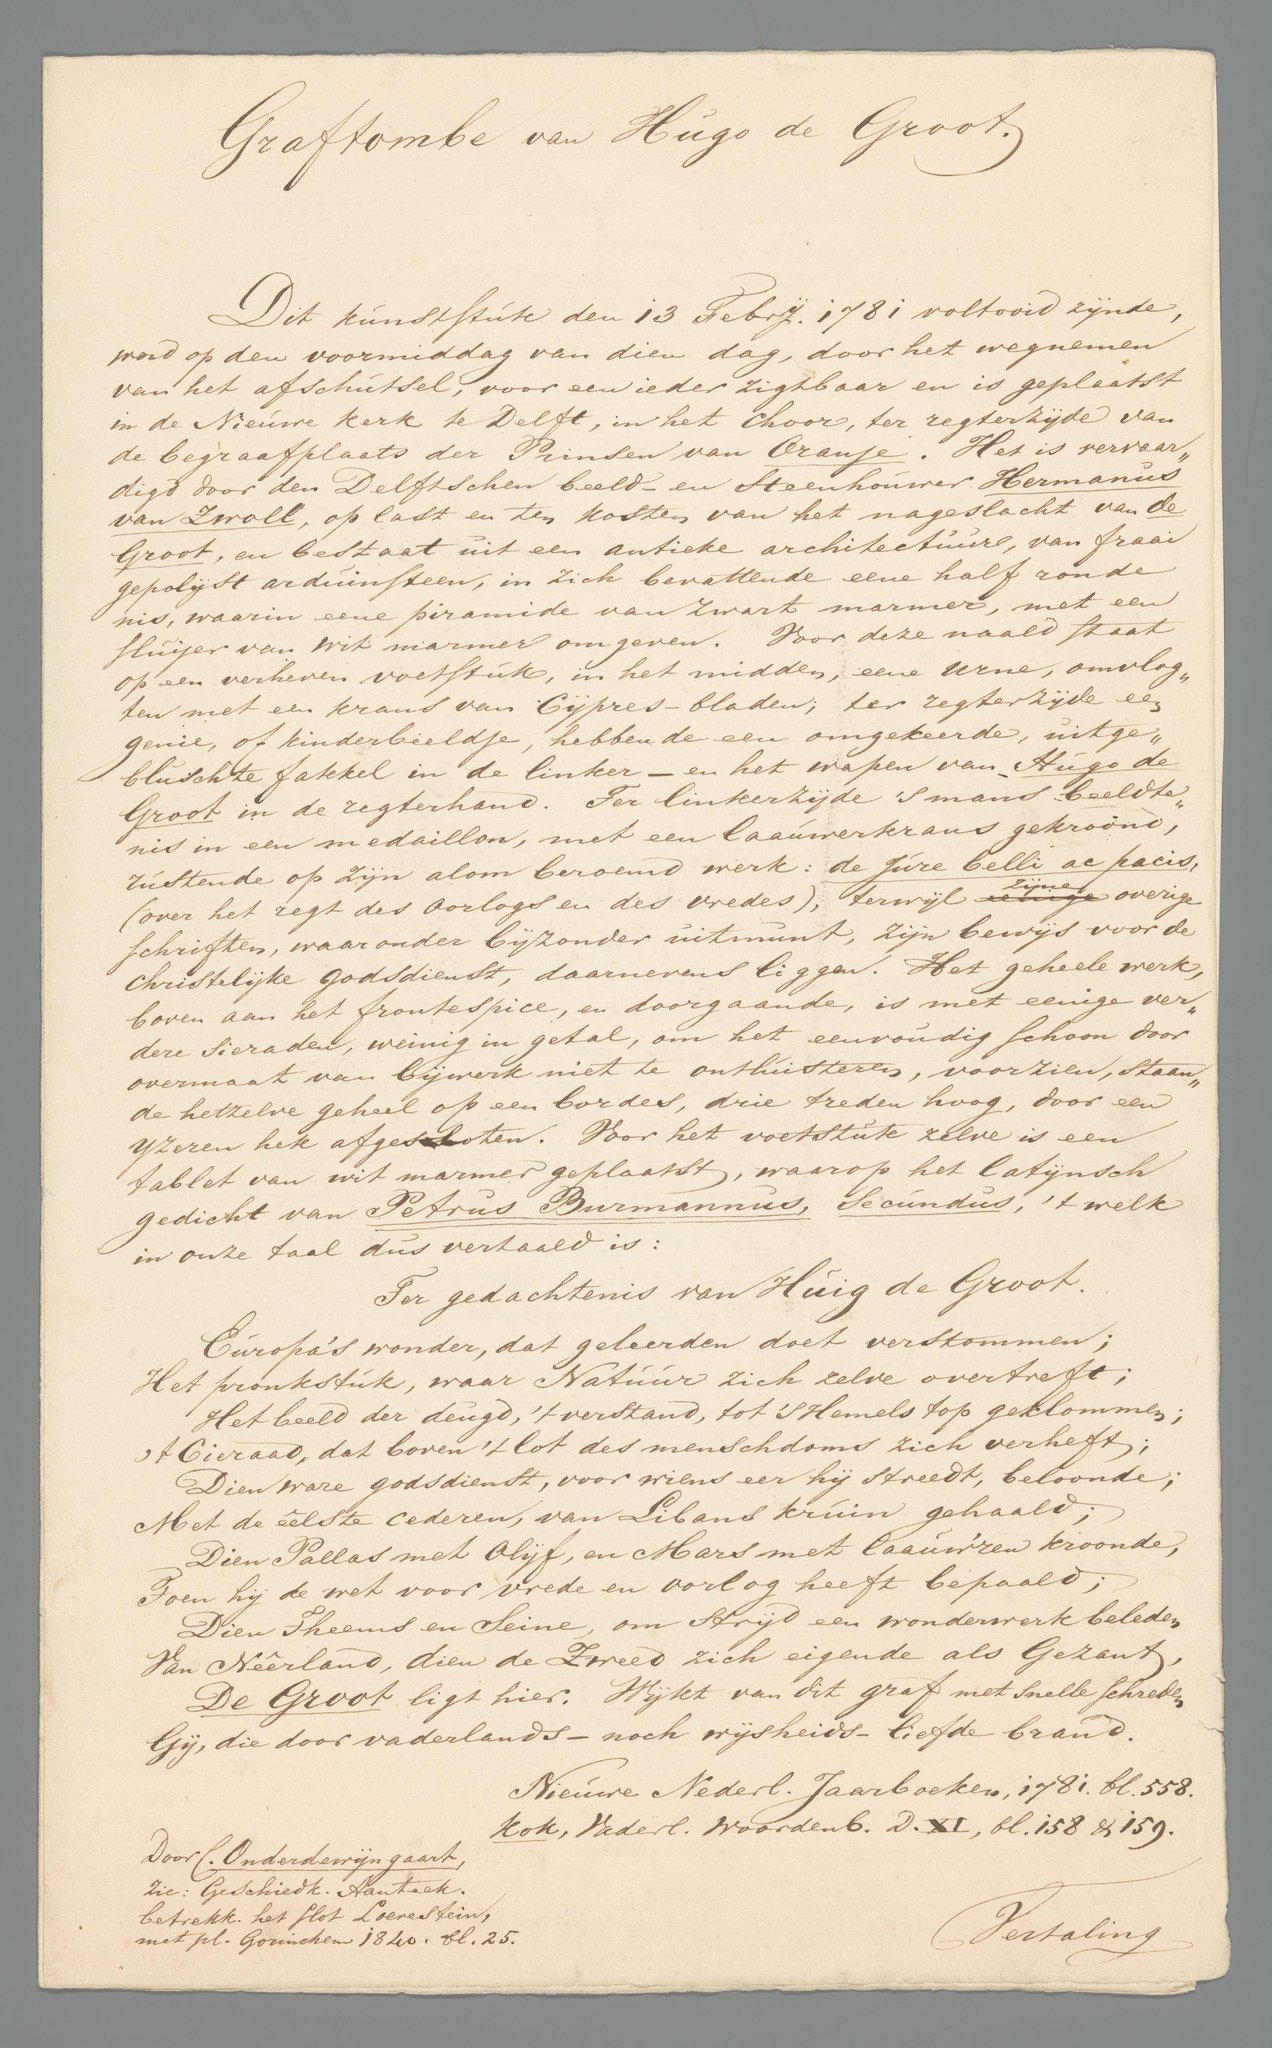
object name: manuscript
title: Graftombe van Hugo de Groot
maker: Anonymous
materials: ink, paper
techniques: pen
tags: grave-building, monumental tomb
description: De beschrijving van de graftombe van Hugo de Groot is deels overgenomen uit het boek: Boonzager, Cornelis Gerhardus, en Johannes van Gendt. Geschiedkundige aanteekeningen betrekkelijk het slot Loevestein (...). Gorinchem: H. Horneer, 1840.